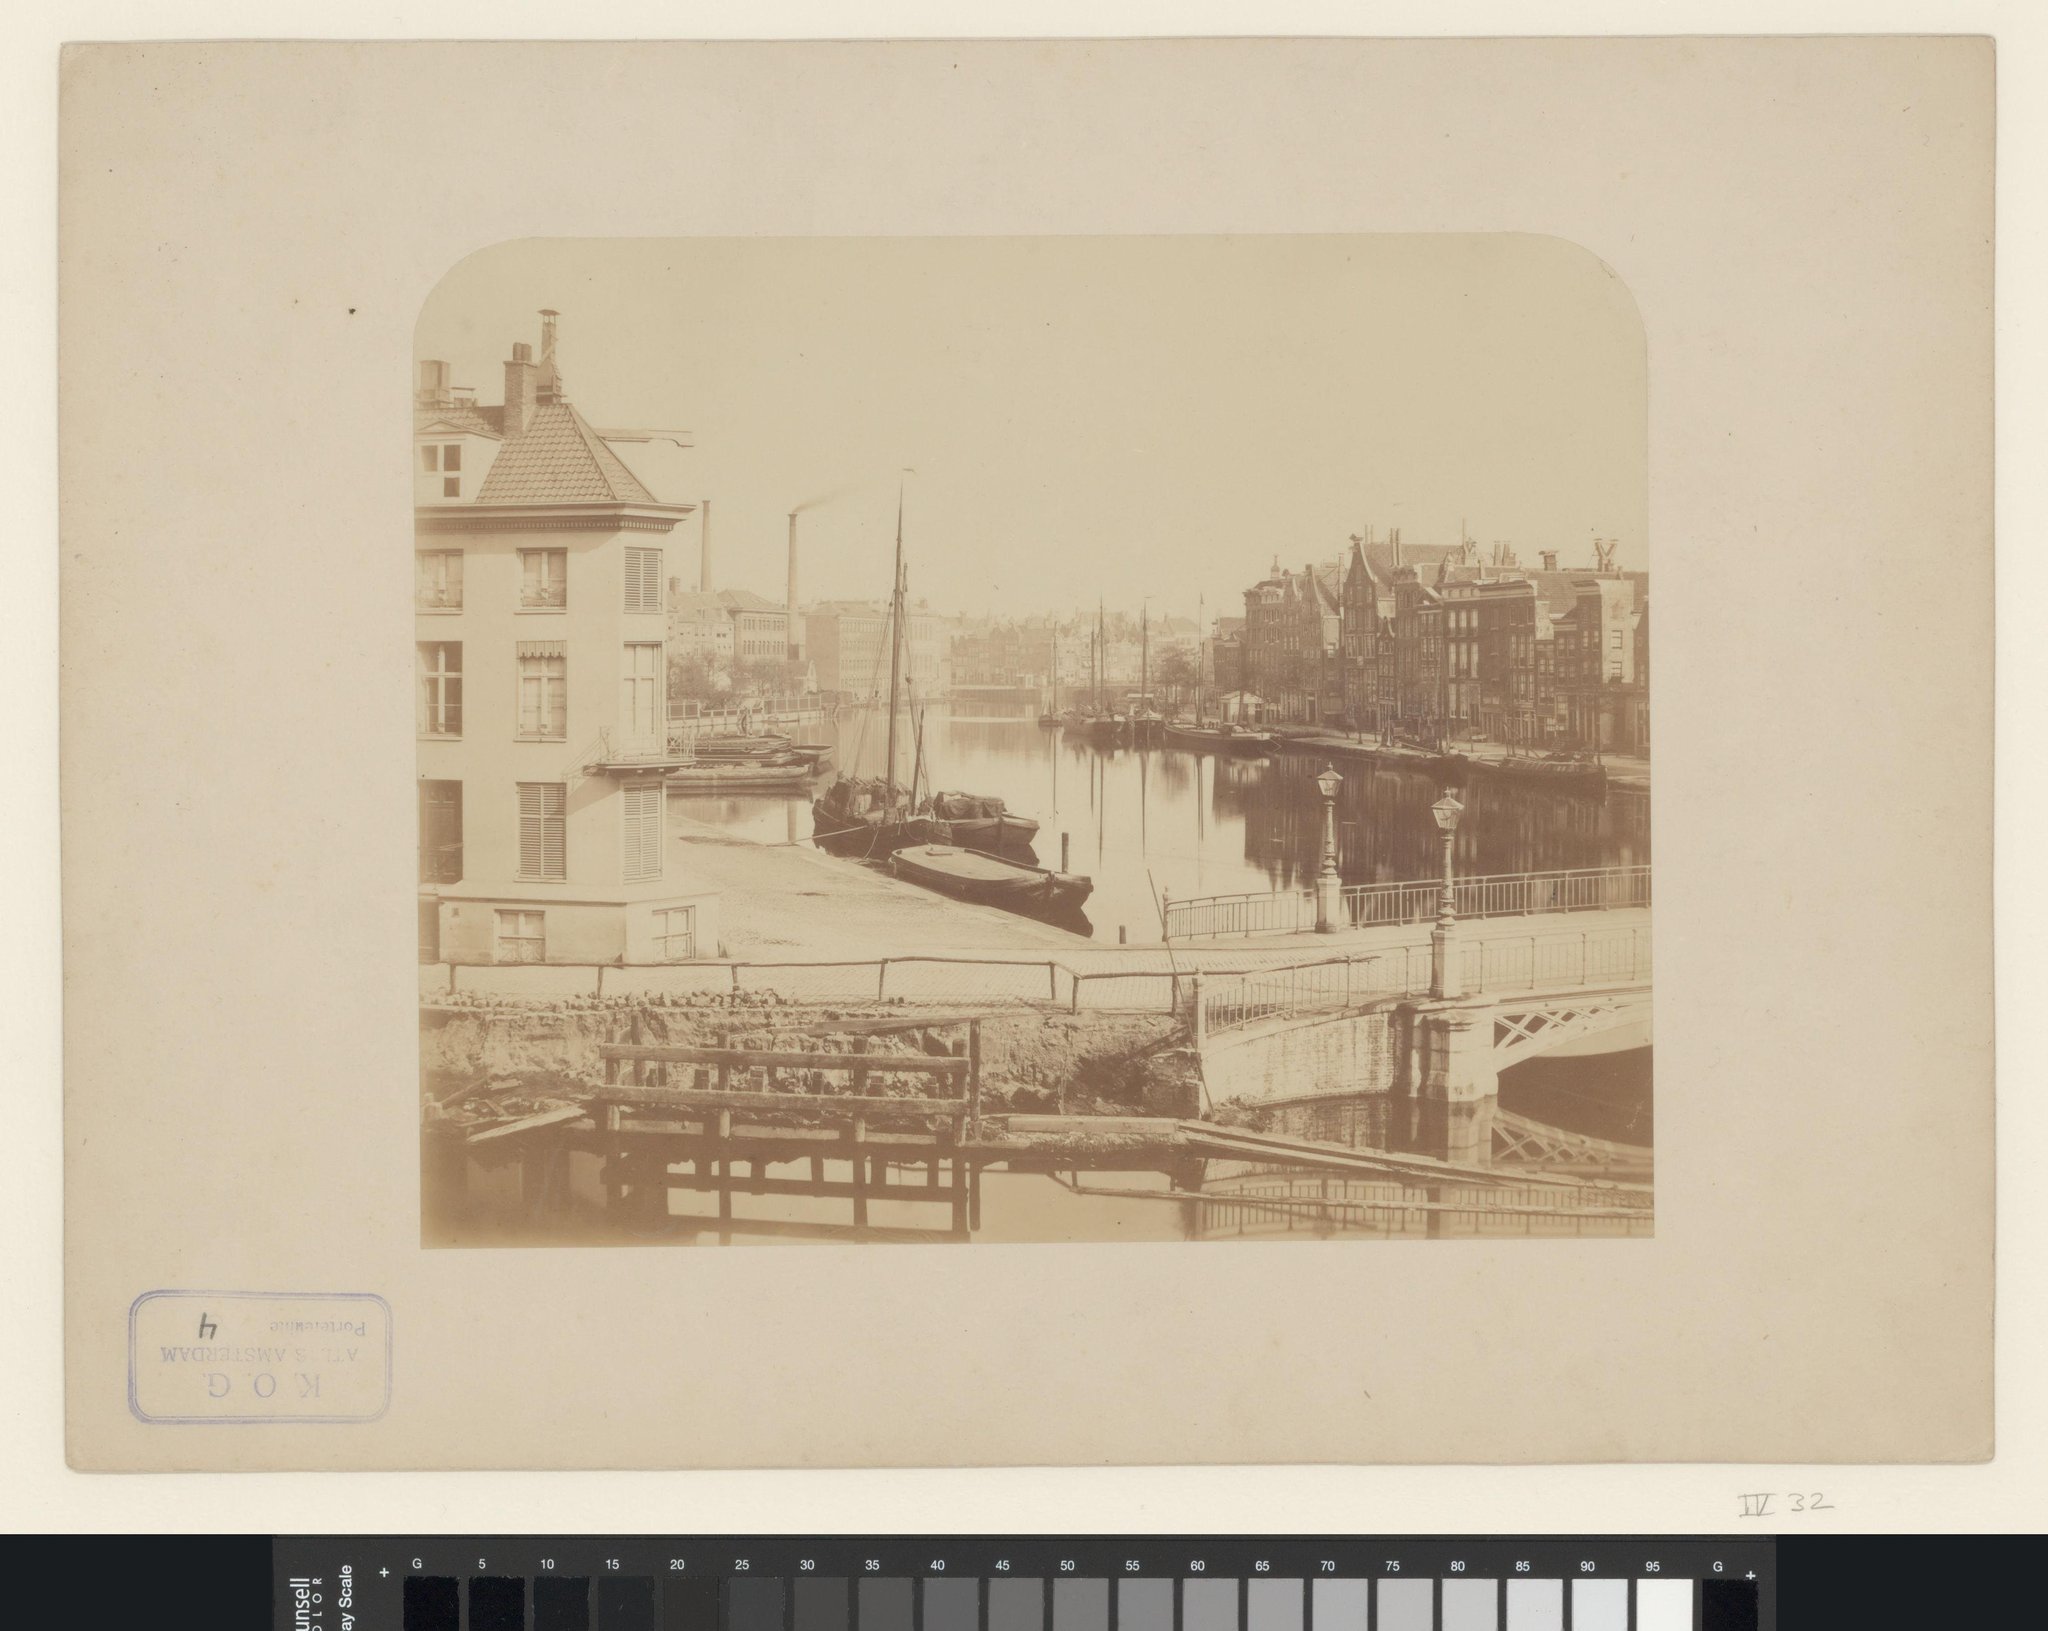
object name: photograph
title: Gezicht op de Binnen-Amstel en de Halvemaansbrug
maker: Anonymous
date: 1863-1915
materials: cardboard, paper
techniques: albumen print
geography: amsterdam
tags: city-view in general; 'veduta', canal, ships (in general), bridge in city across river, canal, etc.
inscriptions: collector's mark: ‘4’ Lugt 1641b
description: Onderwerpsrubriek binnen de Atlas Amsterdam: Amstel van Doelensluis tot Blauwbrug.